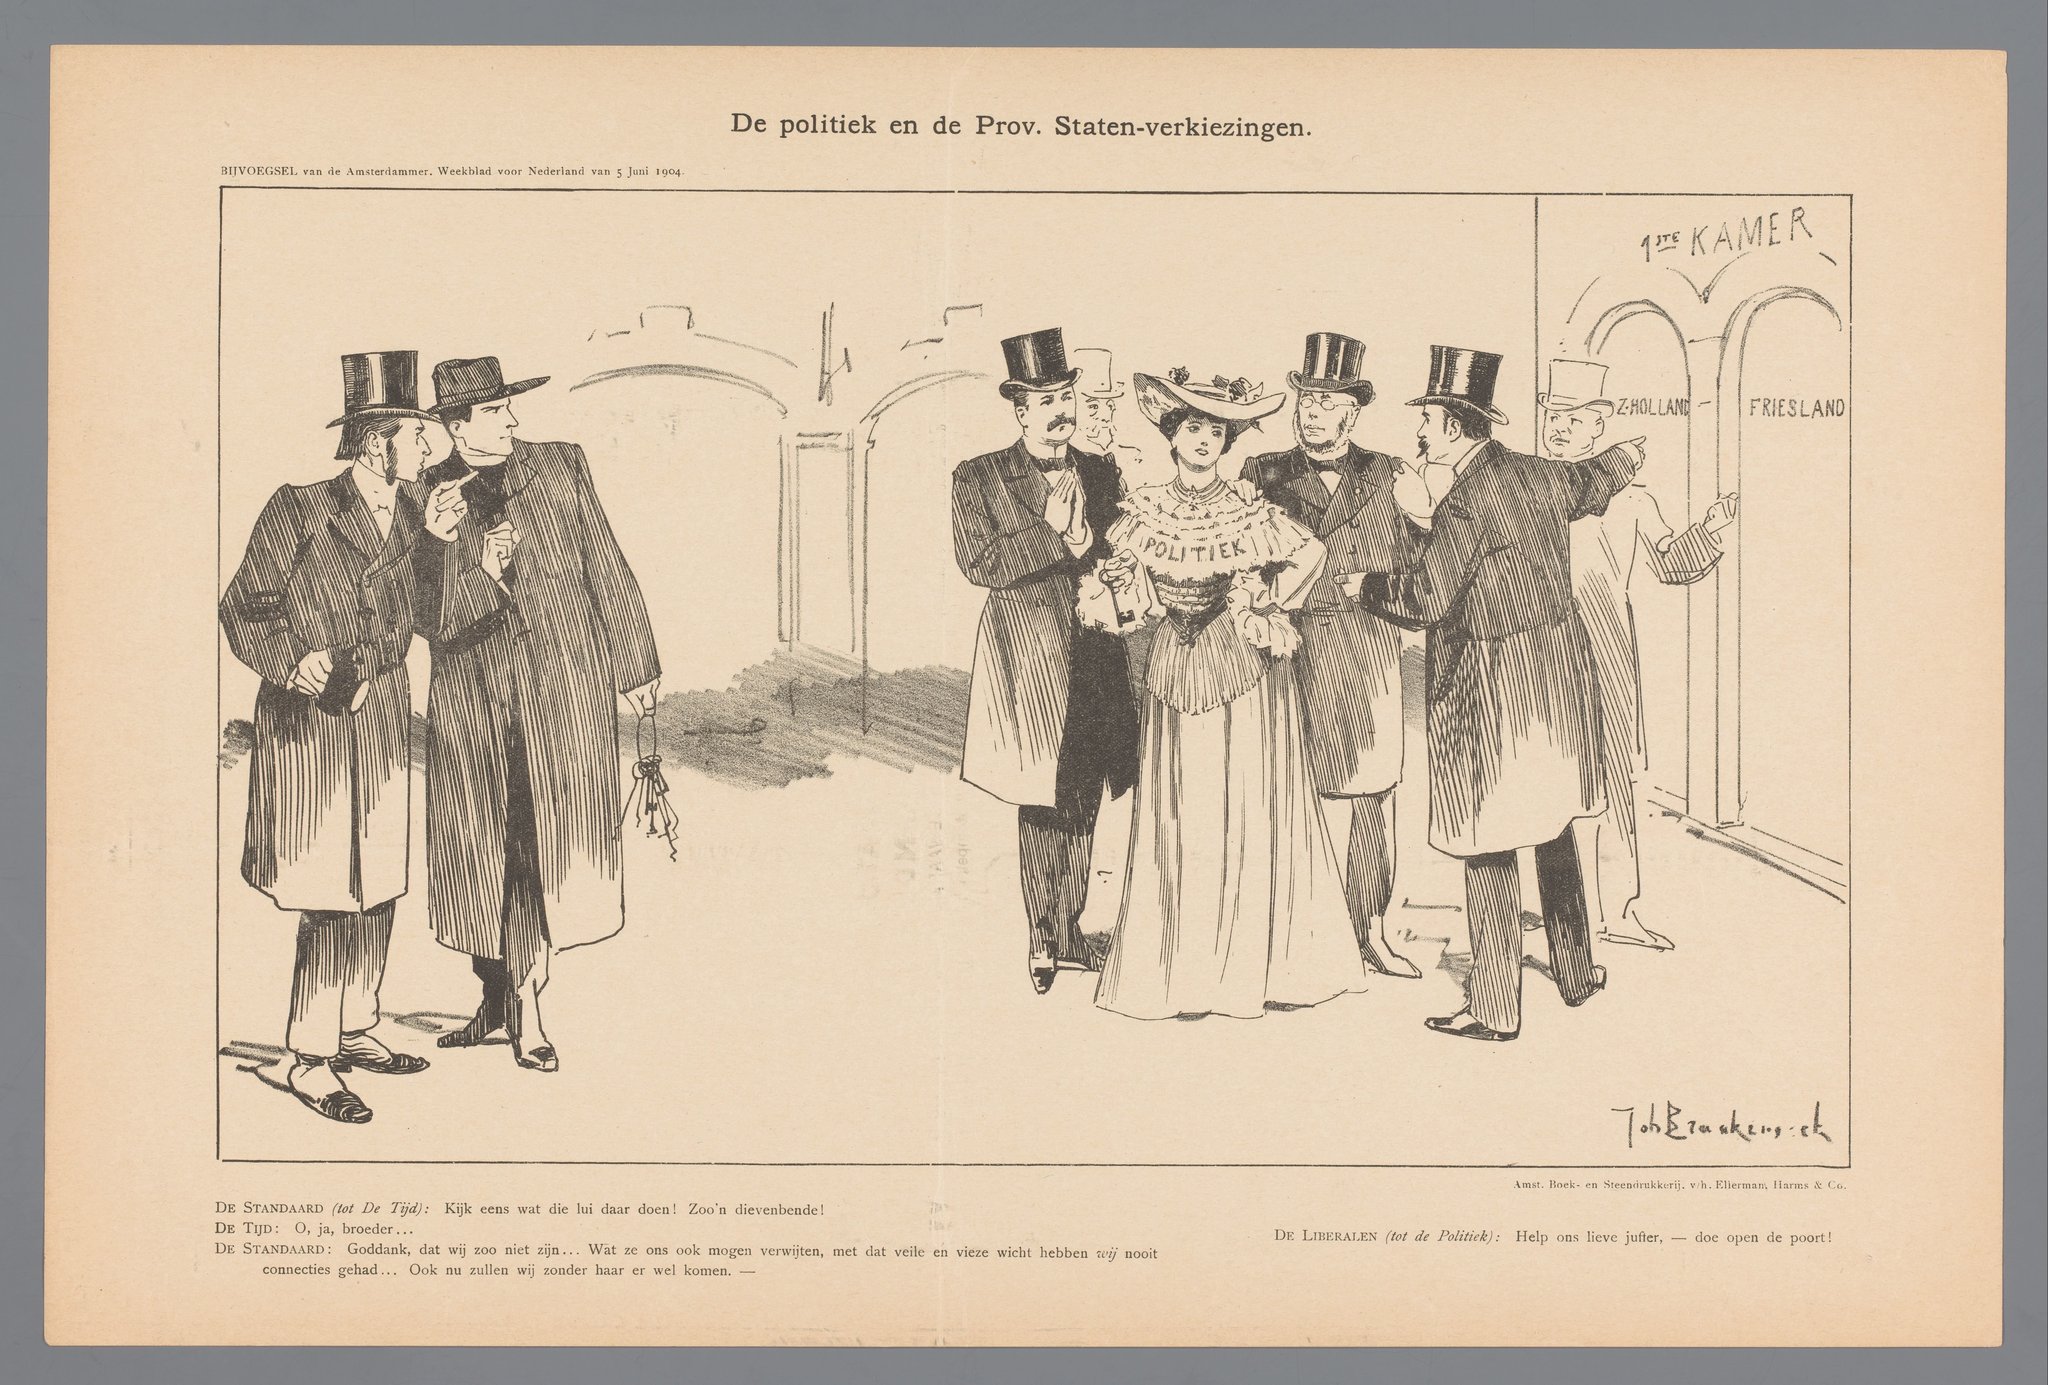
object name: cartoon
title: De politiek en de Prov. Staten-verkiezingen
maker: johan braakensiek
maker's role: draughtsman, print maker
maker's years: 1858-1940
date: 1904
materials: paper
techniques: lithograph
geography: amsterdam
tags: voting, election, political caricatures and satires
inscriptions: date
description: Prent uit het bijvoegsel van: De Amsterdammer. Weekblad voor Nederland, 5 juni 1904.